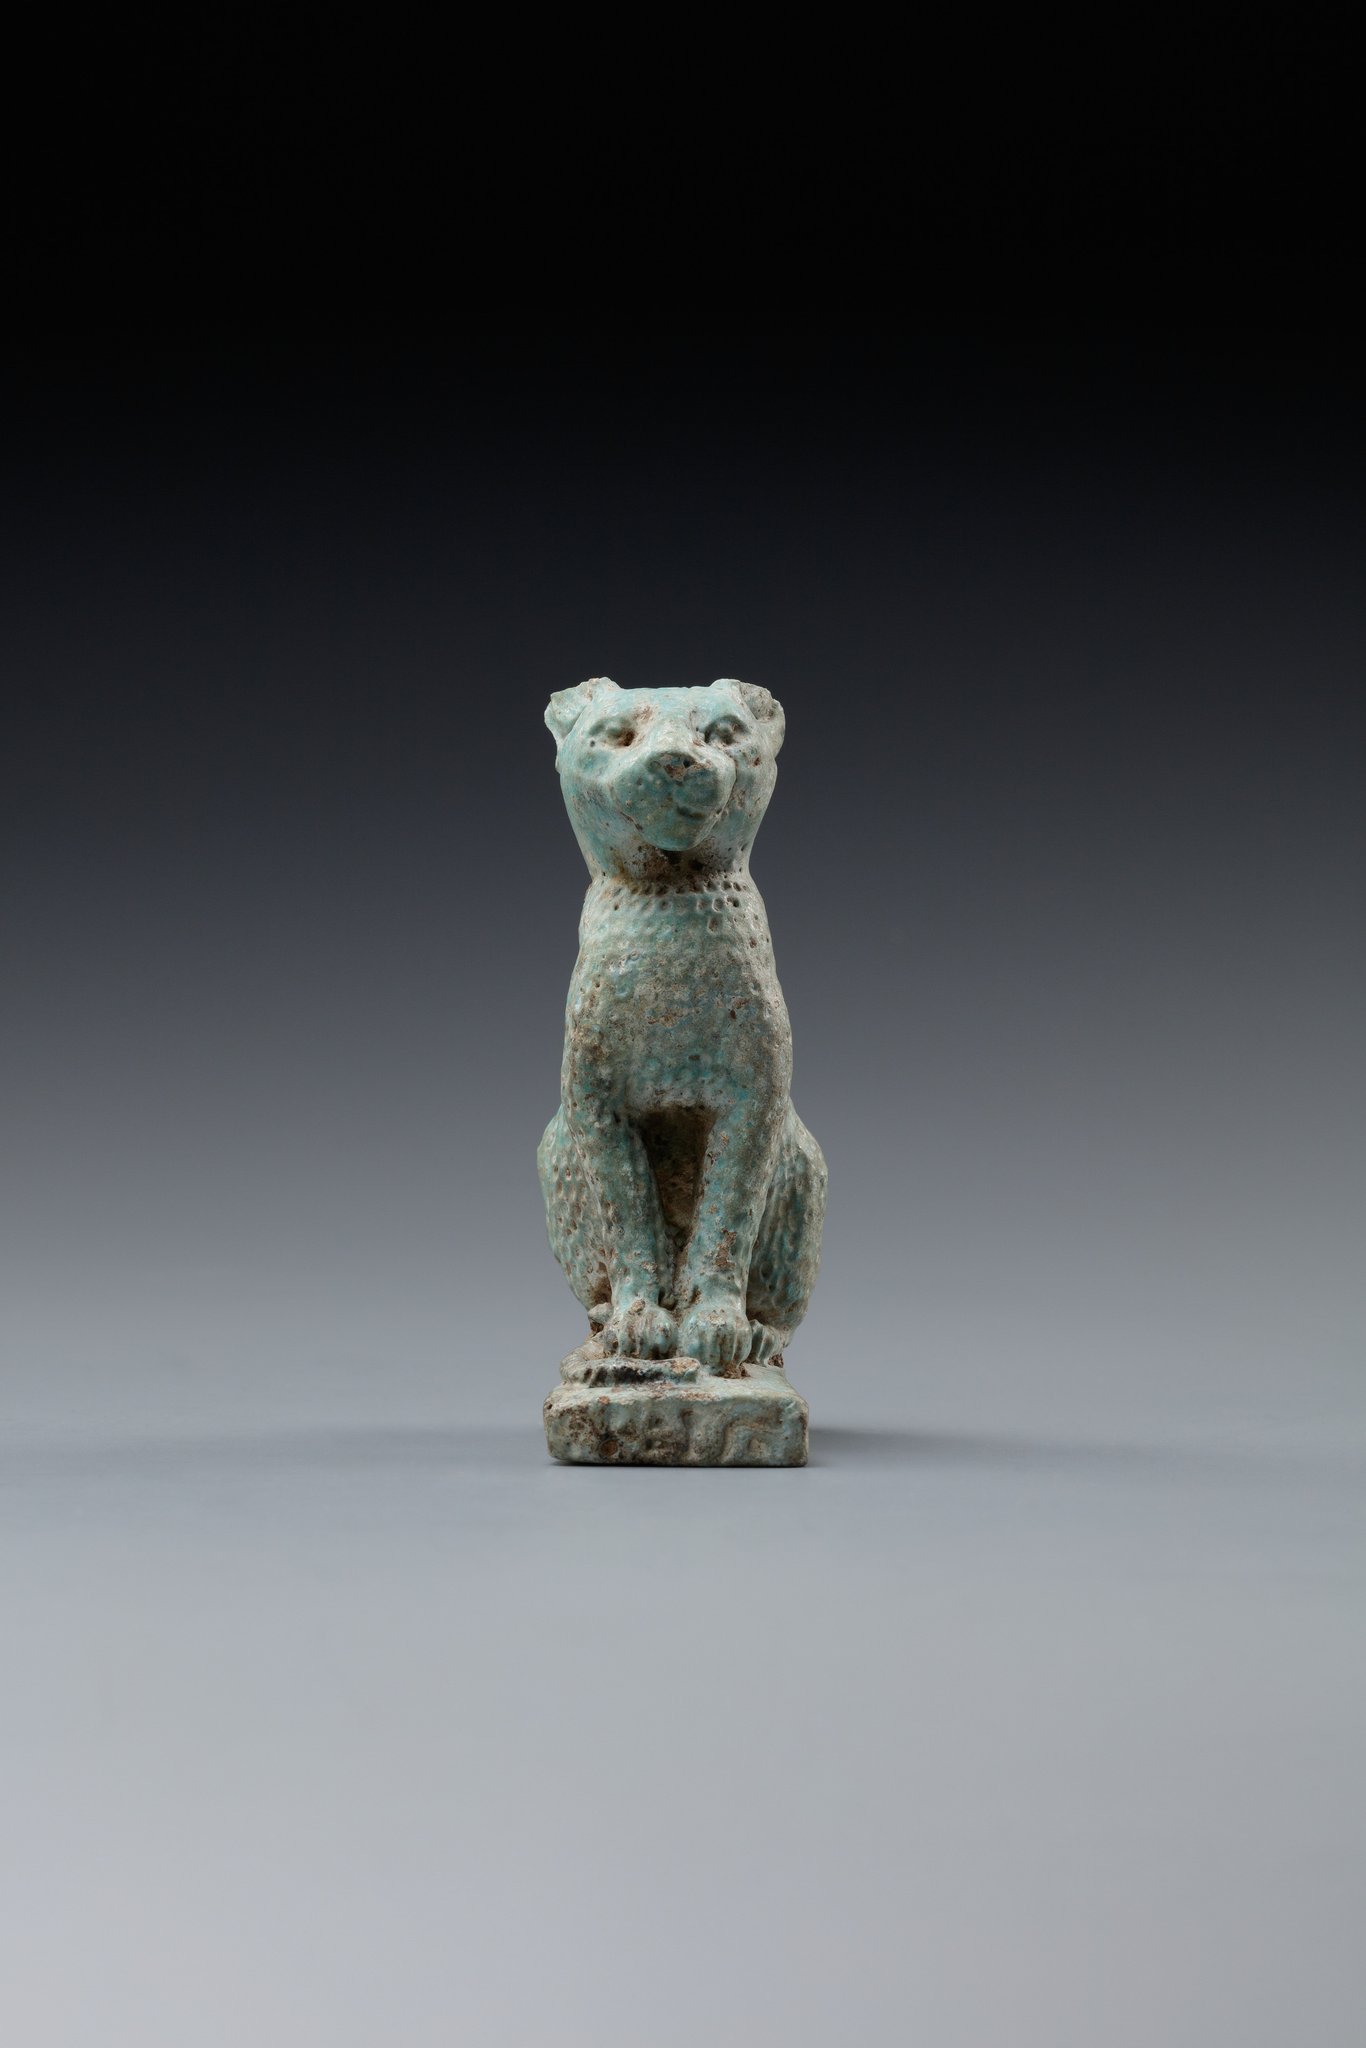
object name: figurine, cat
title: Cat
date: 664-630 BCE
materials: faience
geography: egypt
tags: cats